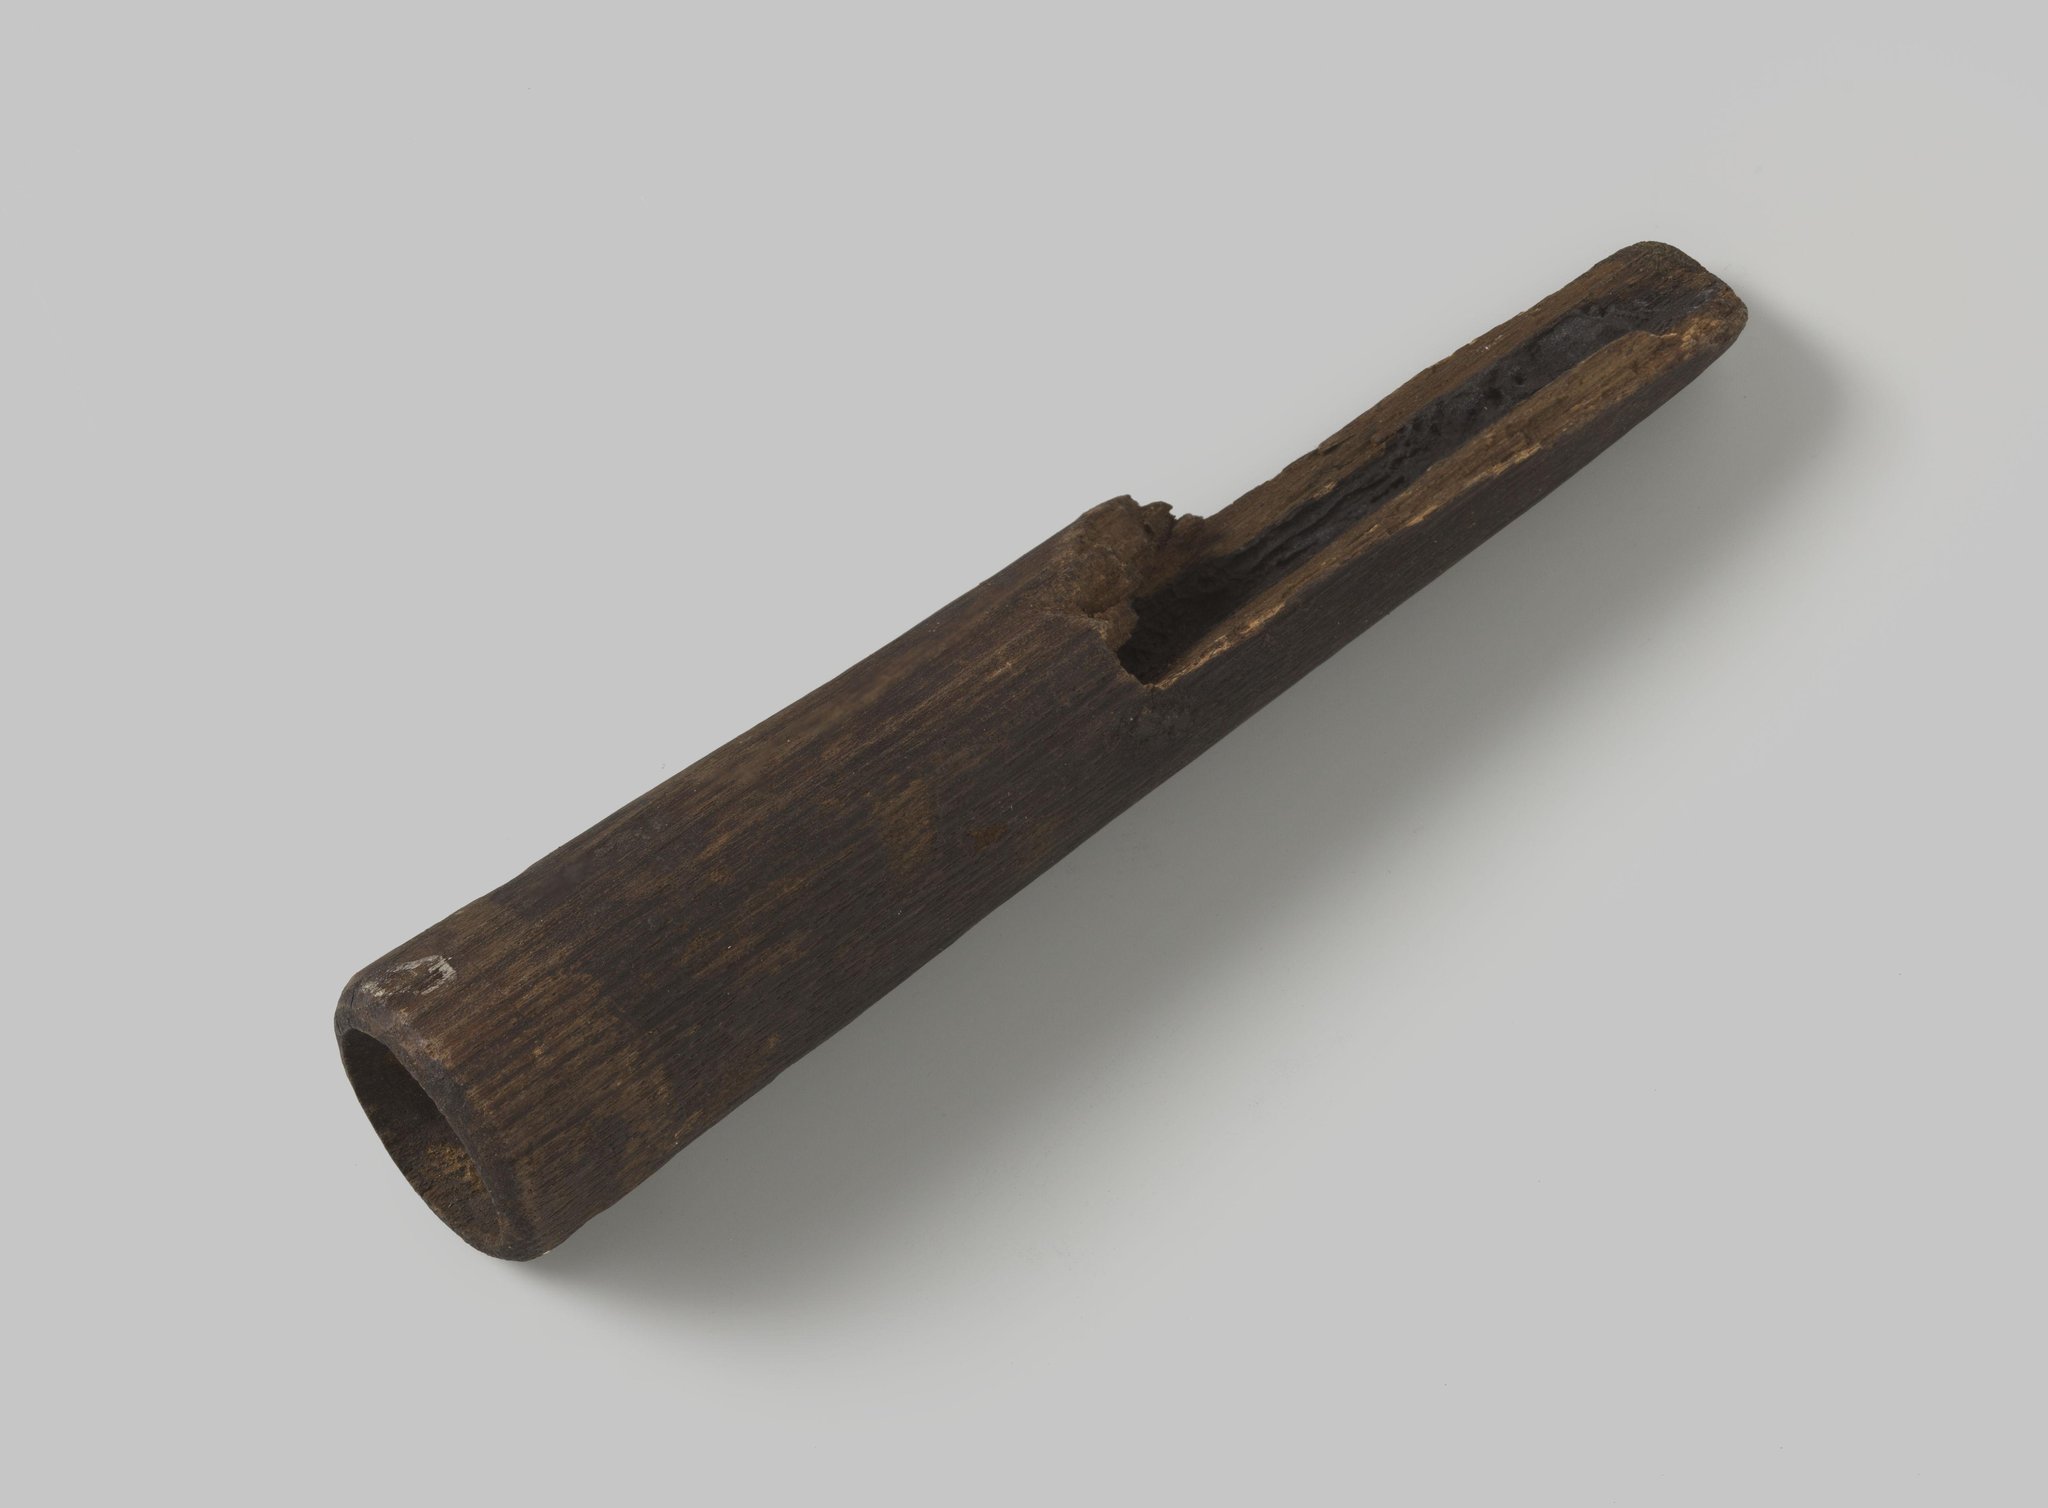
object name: spike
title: Houten pin uit het wrak van de Oostindiëvaarder Hollandia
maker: Anonymous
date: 1700-1743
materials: wood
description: Houten onderdeel, conisch met centrale doorboring.